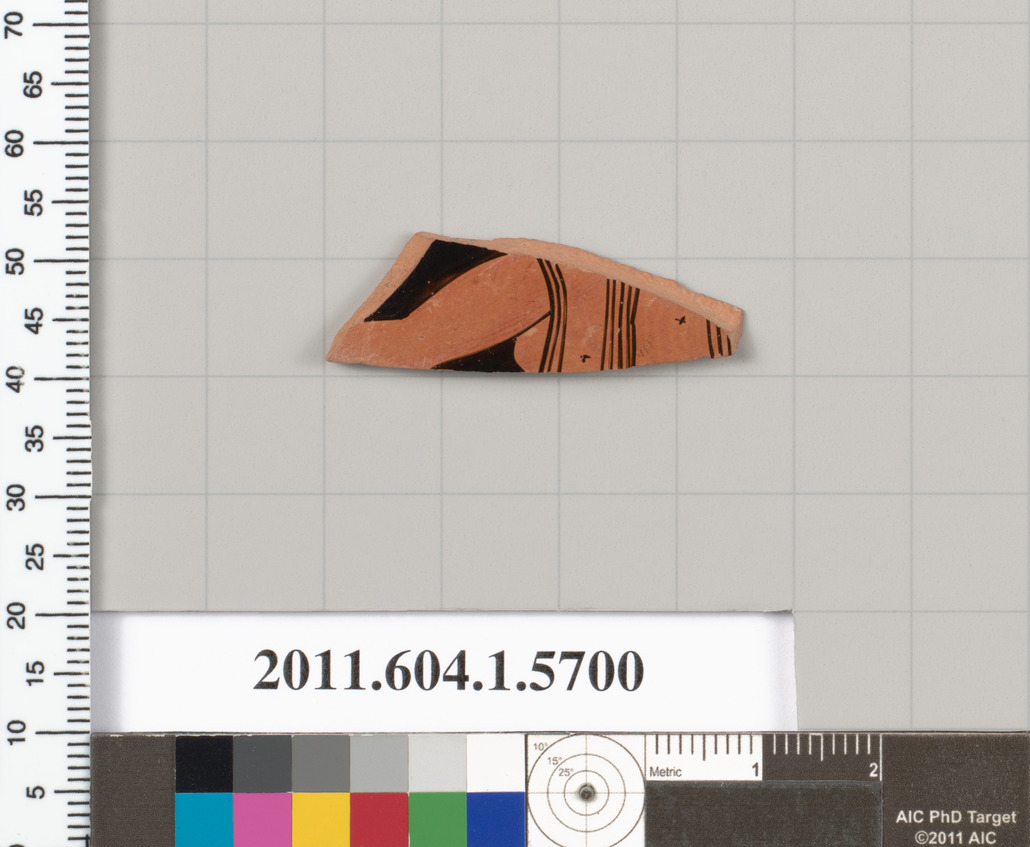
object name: kylix fragment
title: Terracotta fragment of a kylix (drinking cup)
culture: greek, attic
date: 500-480 BCE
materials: terracotta